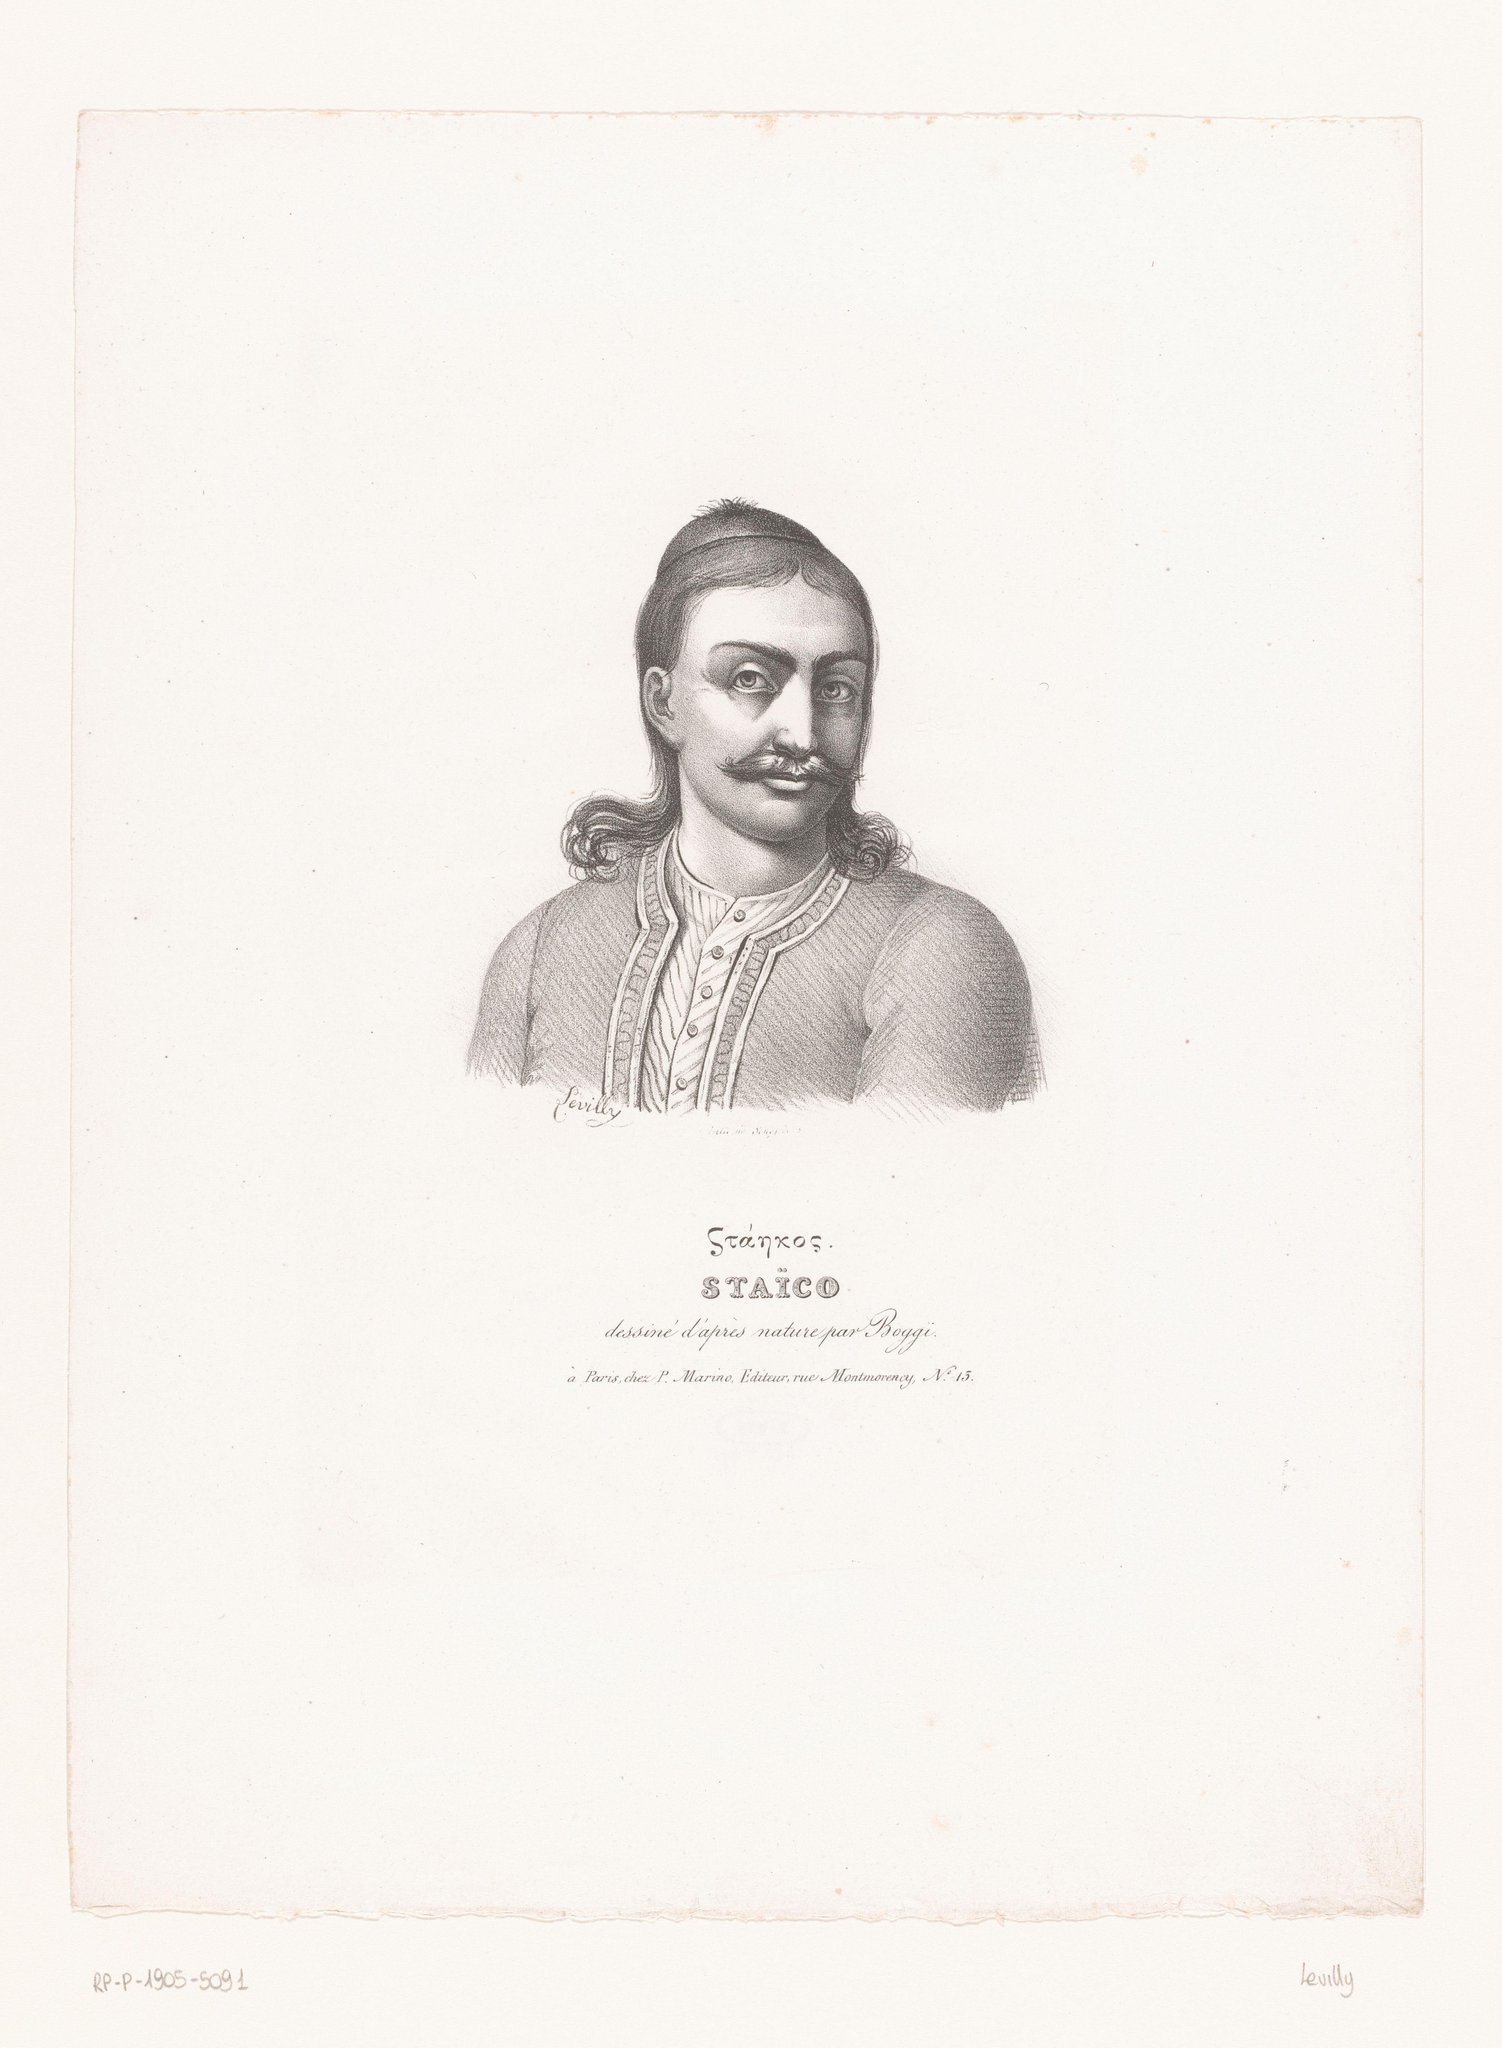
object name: print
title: Portret van Staikos Staikopoulos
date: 1827-1829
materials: paper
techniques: lithograph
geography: paris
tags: historical persons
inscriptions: collector's mark: Lugt 2228